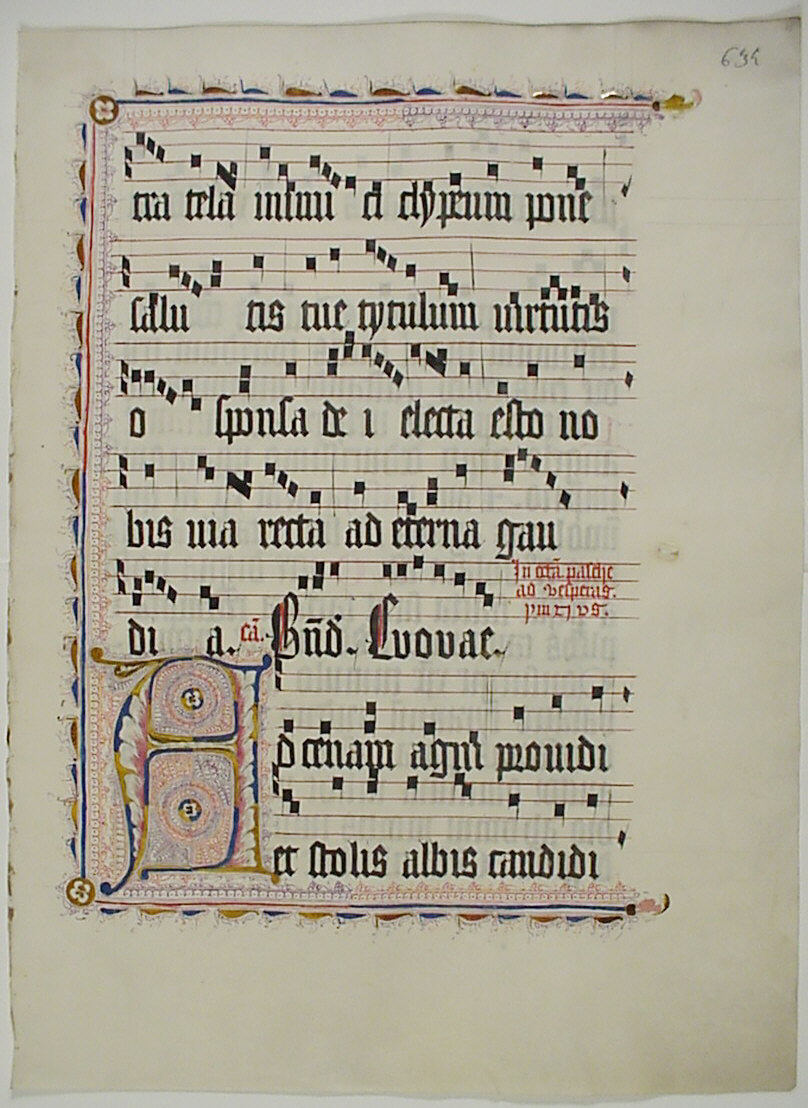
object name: antiphonary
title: Manuscript Leaf with Initial A, from an Antiphonary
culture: german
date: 1426-1450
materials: ink, metal leaf, parchment, paint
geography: germany